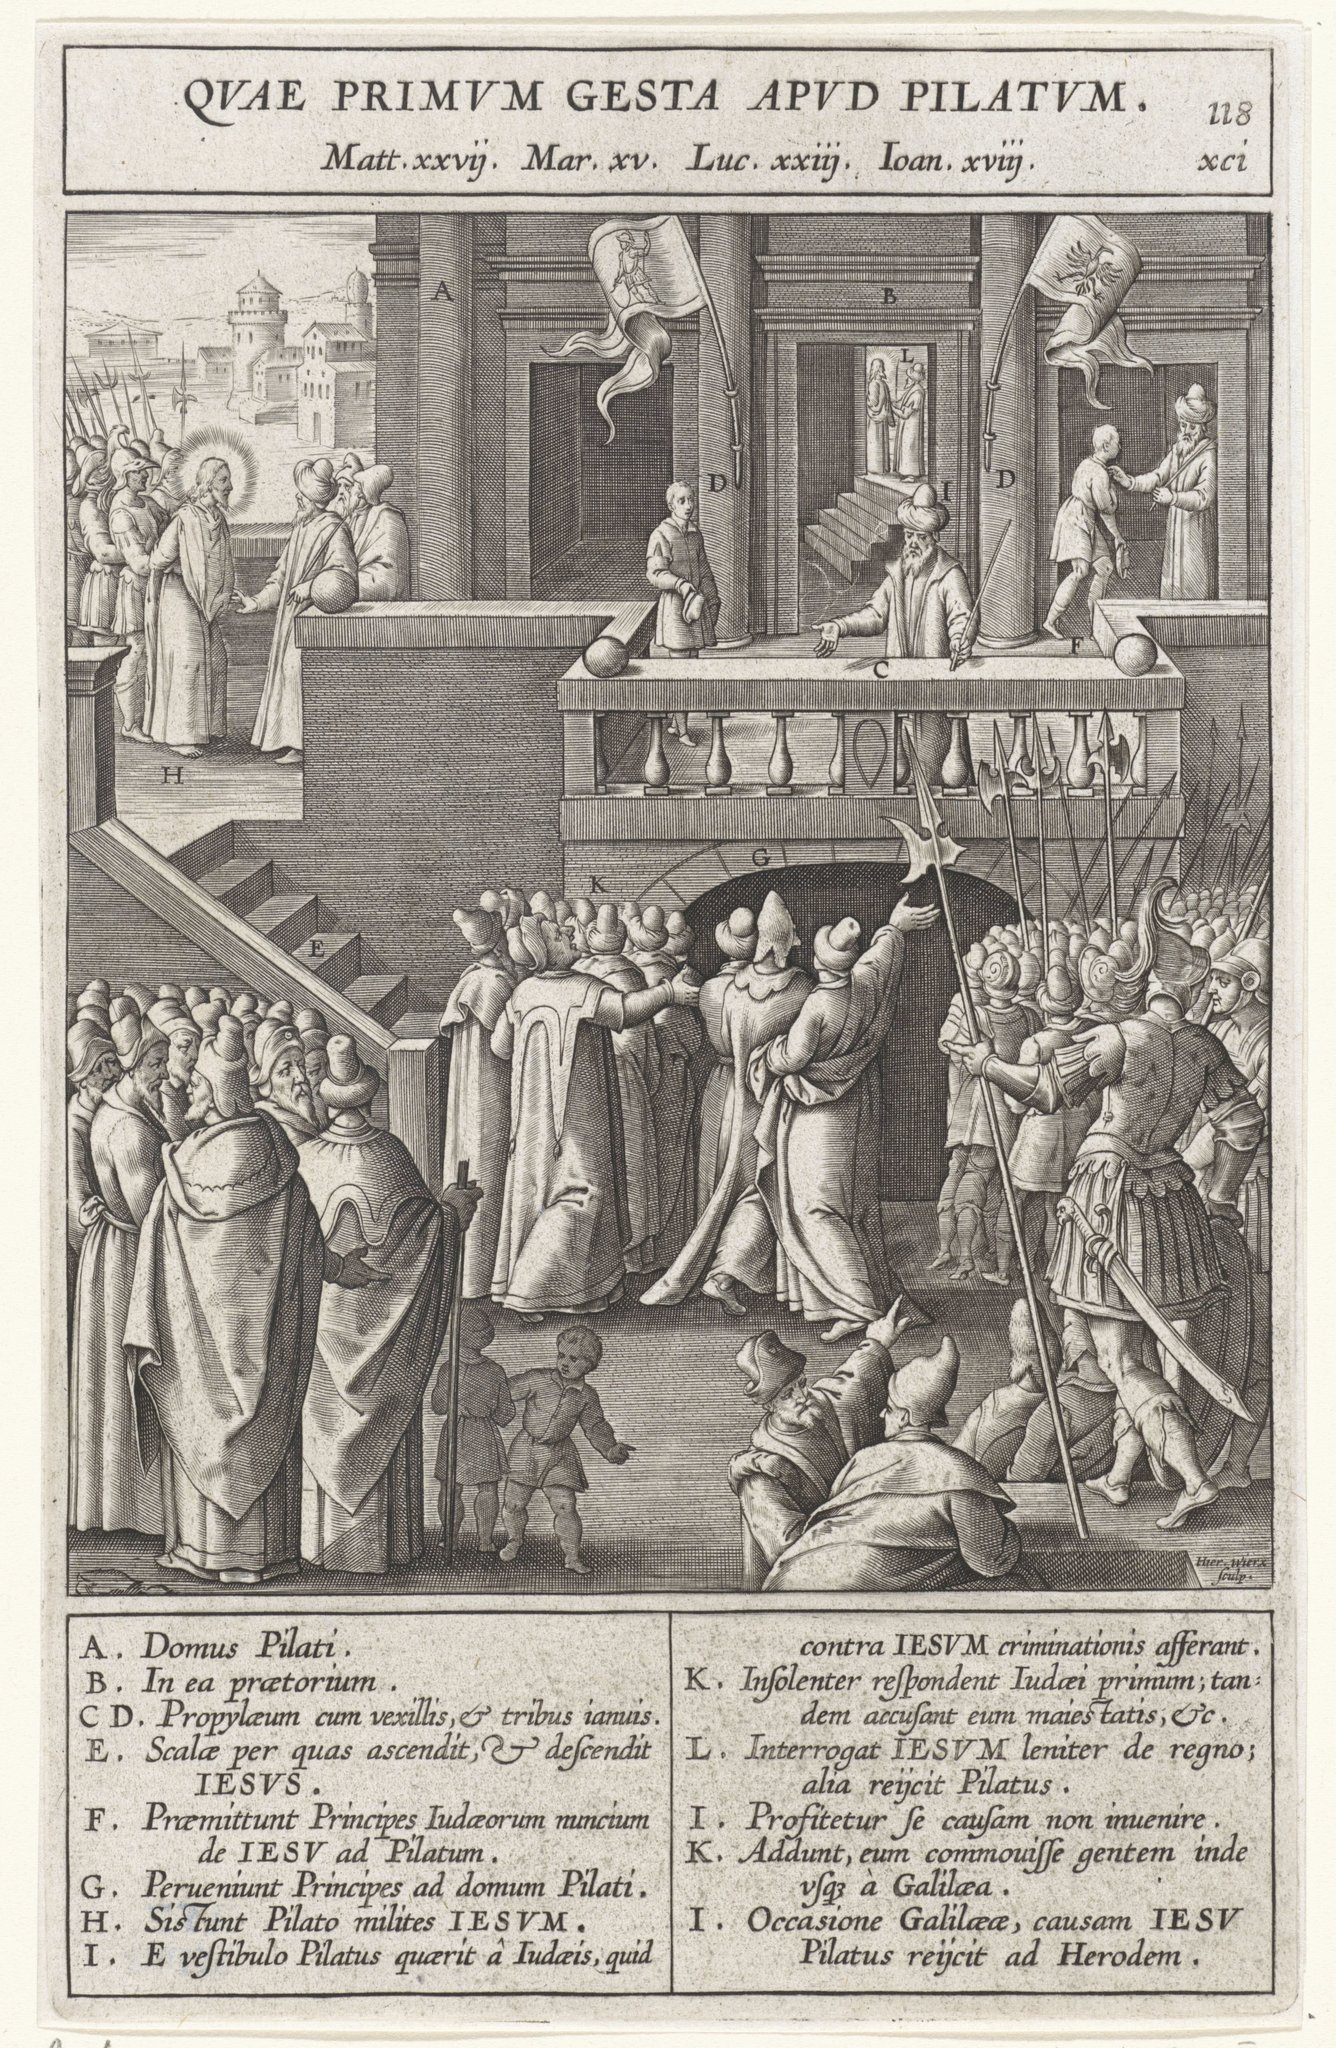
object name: print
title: Christus voor Pilatus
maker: hieronymus wierix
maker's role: draughtsman, print maker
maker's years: 1553-1619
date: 1593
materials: paper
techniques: engraving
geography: antwerp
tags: christ before pontius pilate (matthew 27:11-26; mark 15:2-15; luke 23:2-7, 23:13-25; john 18:28 - 19:16), pilate in debate with the jews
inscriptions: collector's mark: Lugt 2165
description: Christus wordt door gewapende soldaten voor Pilatus gebracht. Pilatus vraagt de samengestroomde menigte welke gevangene hij vrij moet laten. Bij verschillende elementen uit de voorstelling staan letters die corresponderen met de legenda in de marge.